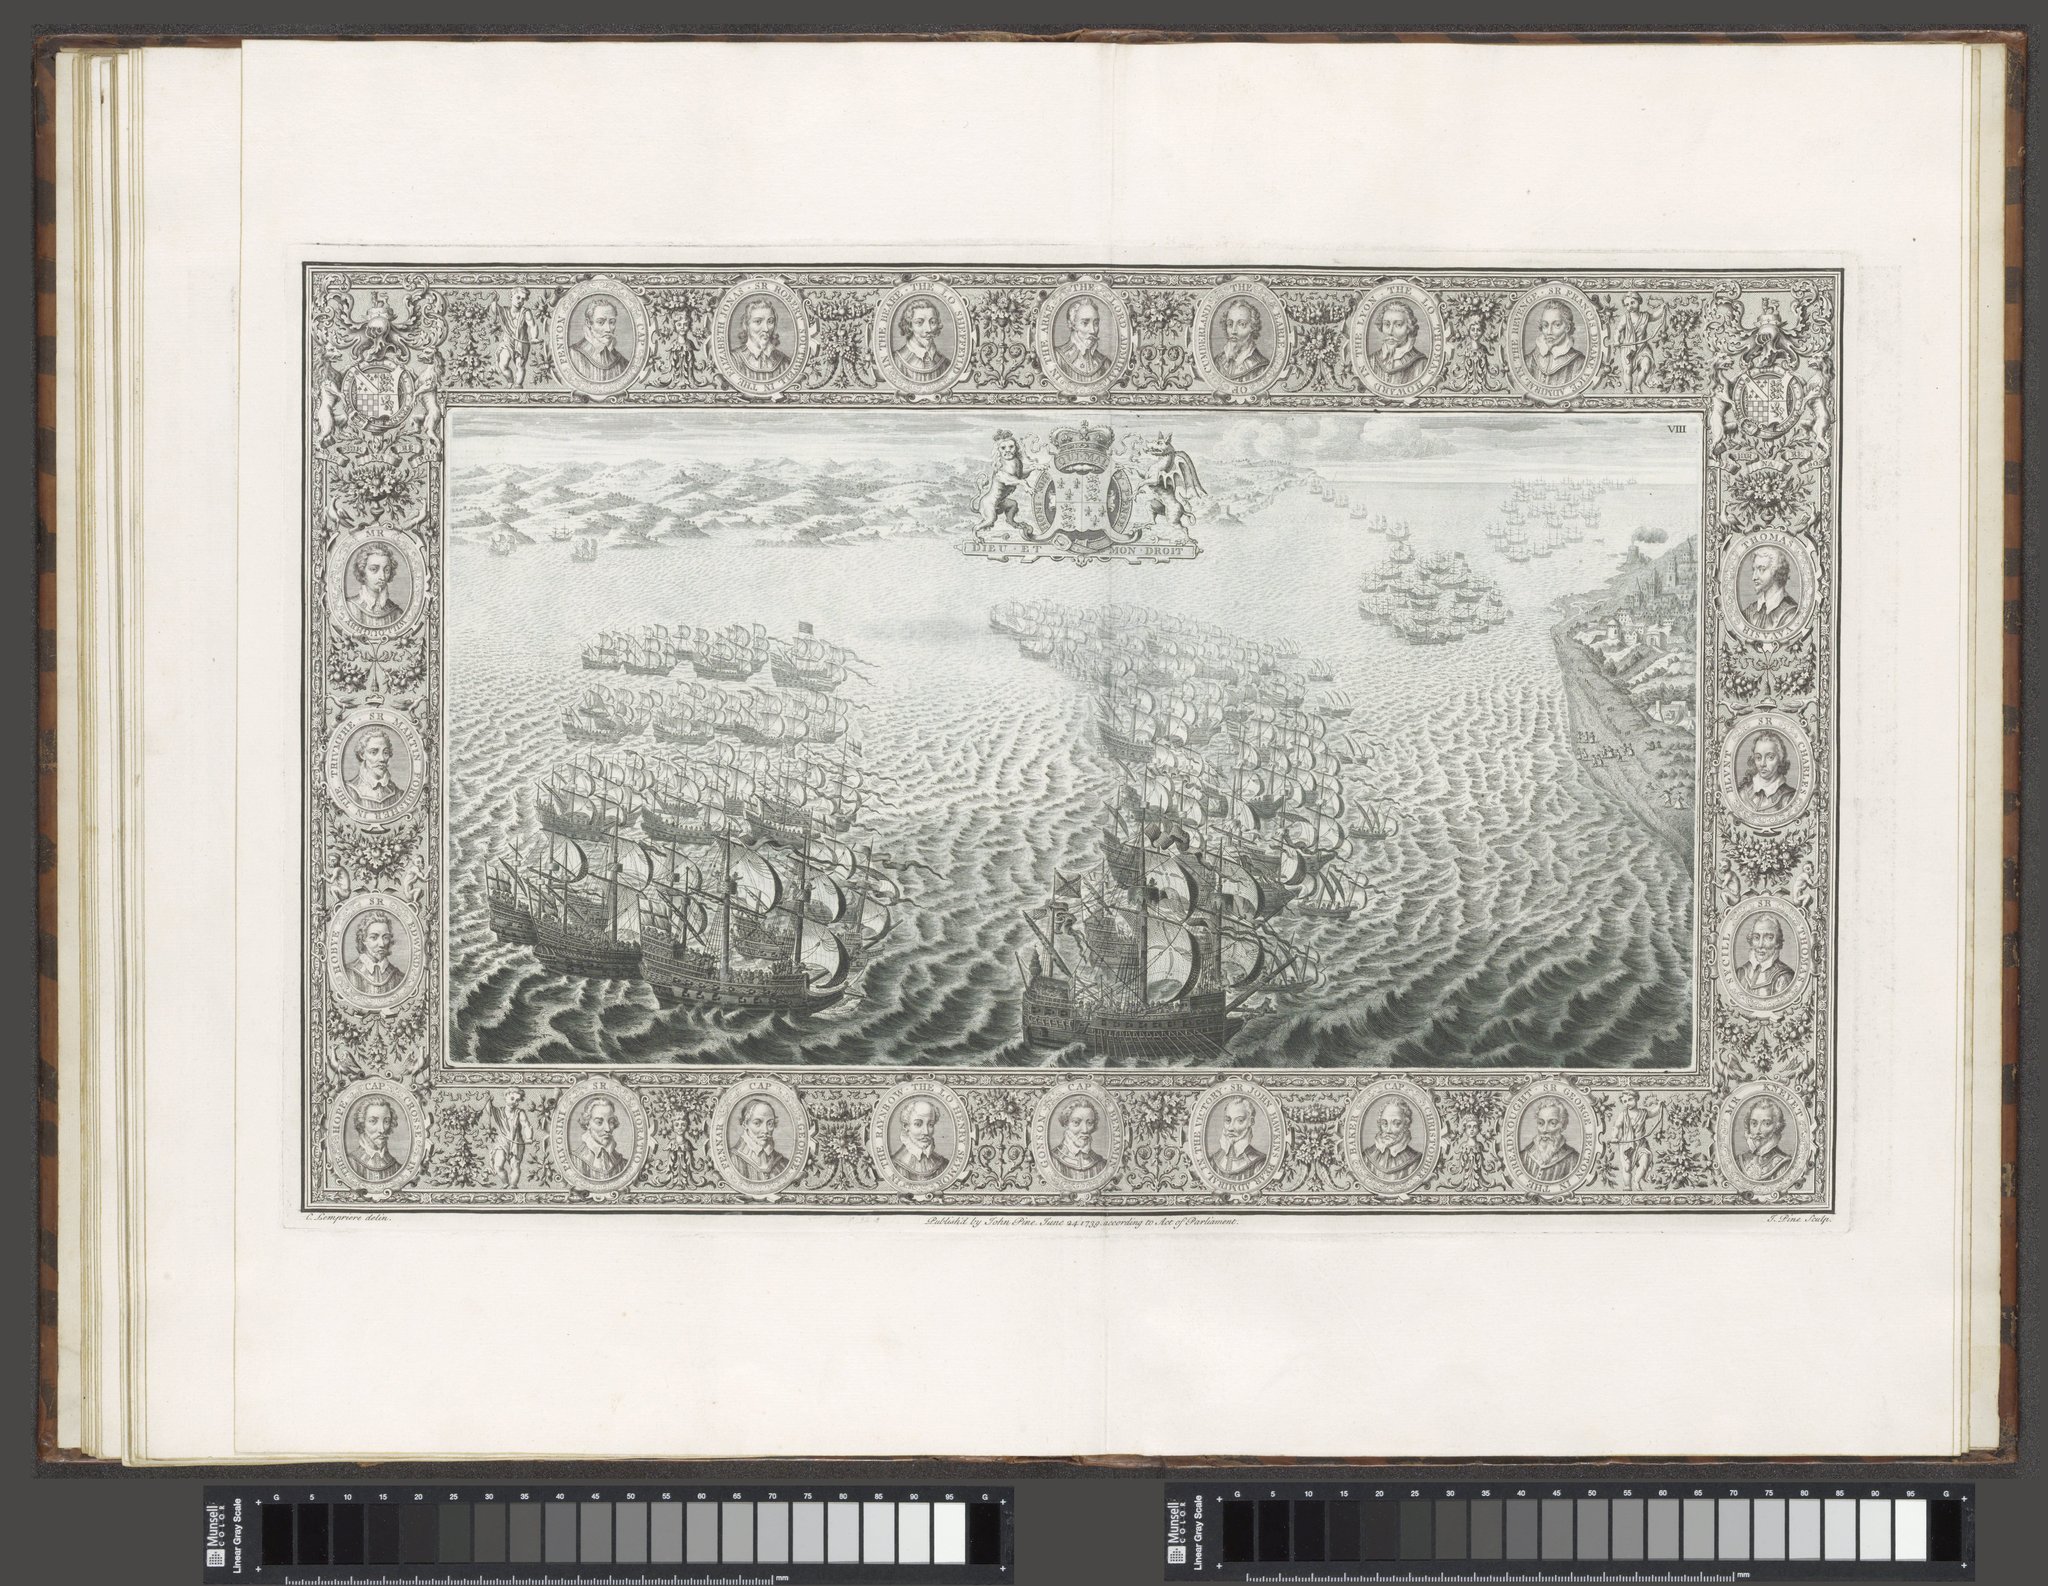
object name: print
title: Reproductie van een wandtapijt over de Spaanse Armada (26-27 juli)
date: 1739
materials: paper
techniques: engraving, etching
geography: london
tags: plymouth, politician, coat of arms (as symbol of the state, etc.), monkeys, apes, birds, battle (+ naval force), tapestry, armorial bearing, heraldry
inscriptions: date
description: Reproductie van een wandtapijt gemaakt in opdracht van Charles Howard (1536-14 december 1624), Lord High Admiral. Het tapijt werd geweven door Francis Aertsz Spierincx in Delft, naar het karton van Hendrik Cornelisz Vroom. Vroom gebruikte als leidraad voor zijn ontwerp een getekende kaart van Robert Adams uit 1588 of de prent die daarvan twee jaar later werd gemaakt en uitgegeven door Augustine Ryther. Deze reproductie werd volgens de tekst van de prent gegraveerd door John Pine naar de tekening die Clement Lemprière van het tapijt maakte. Het tapijt zelf ging in 1834 bij een brand verloren.